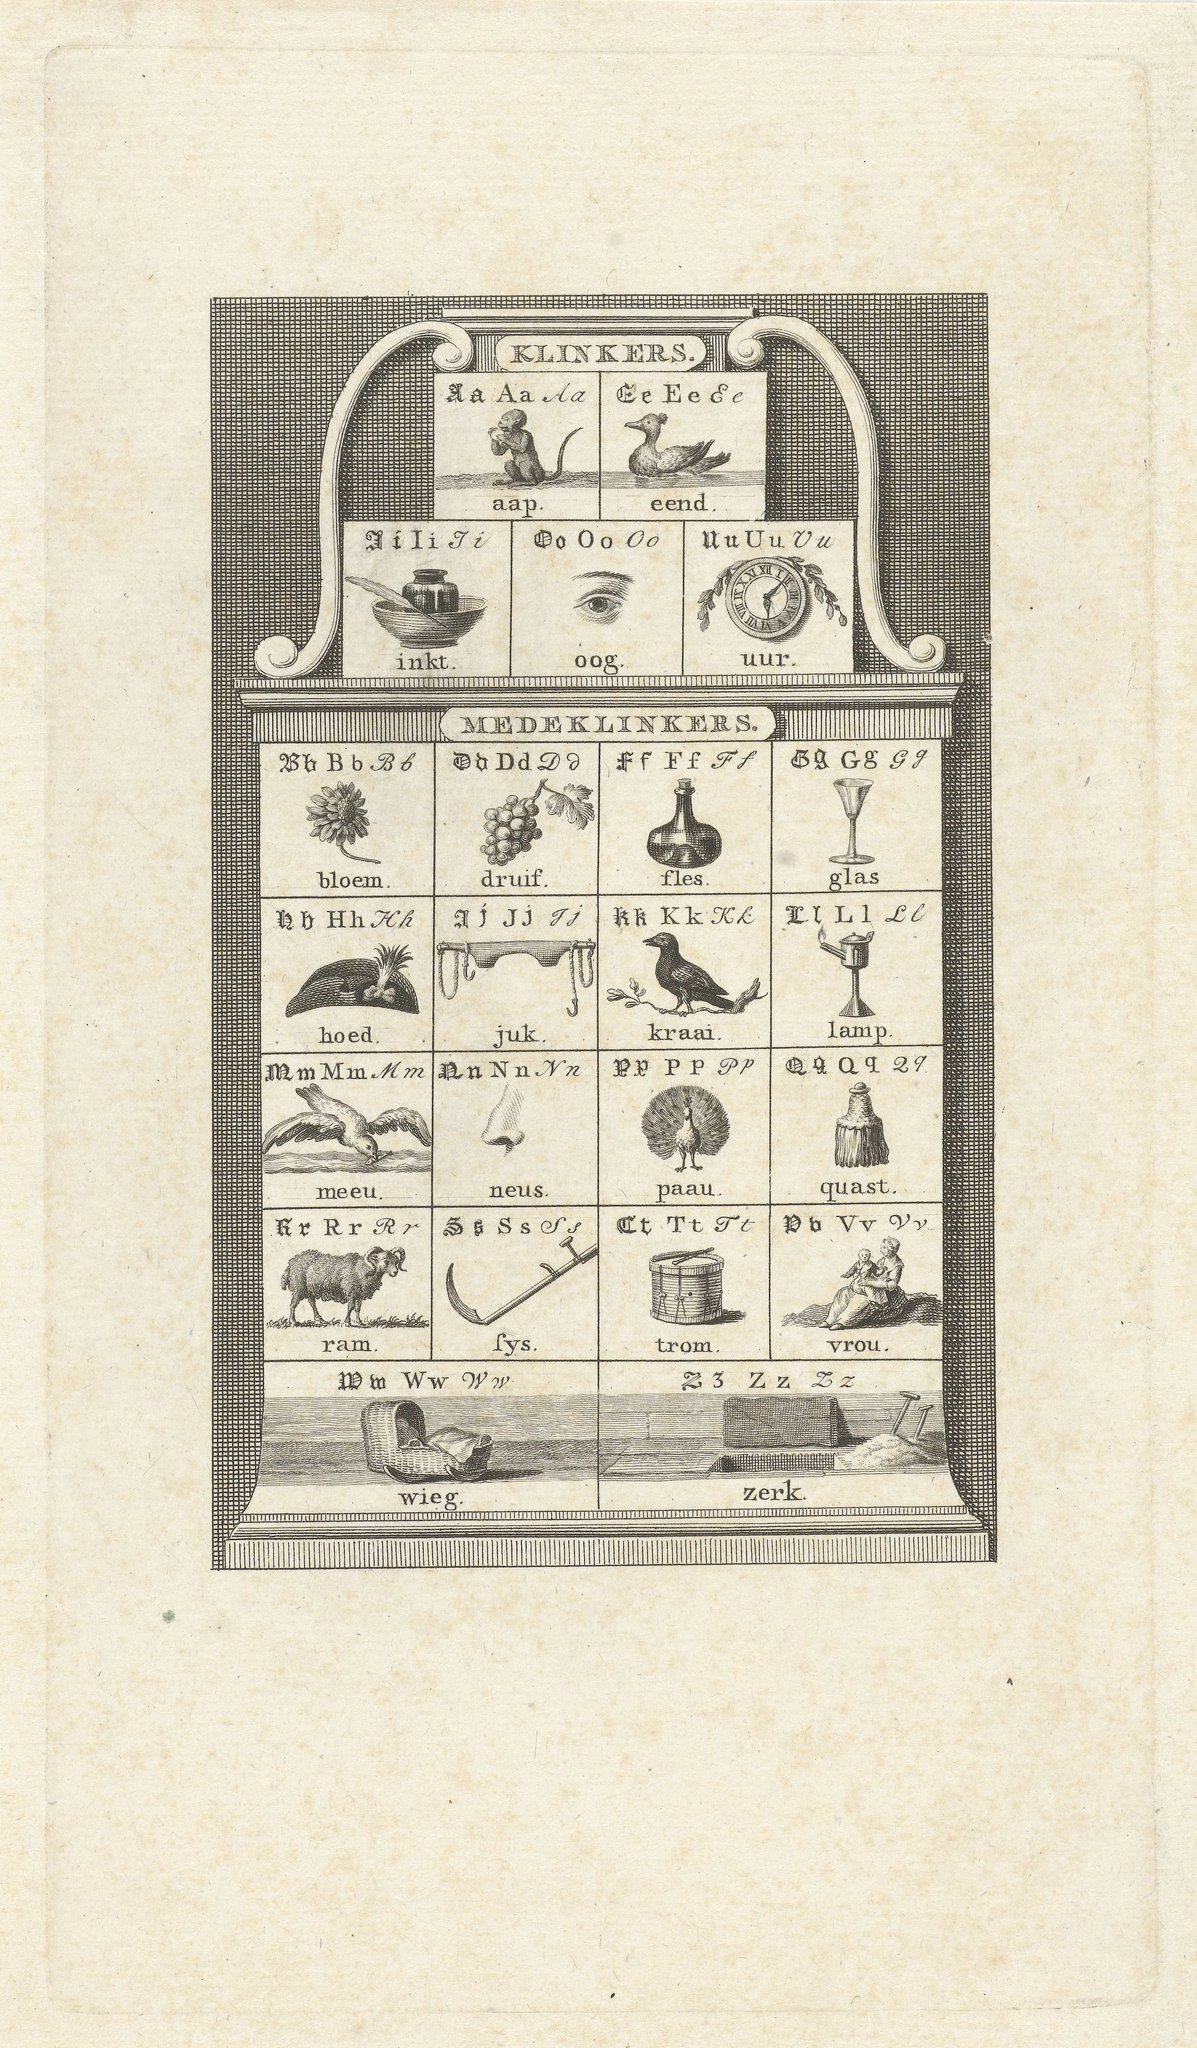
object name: print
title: Letters van het alfabet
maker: jacob folkema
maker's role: draughtsman, print maker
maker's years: 1692-1767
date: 1702-1767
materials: paper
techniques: etching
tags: letters, alphabet, script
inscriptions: collector's mark: Lugt 2228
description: De letters van het alfabet, gegroepeerd in klinkers en medeklinkers. Bij elke letter staat een afbeelding van een voorwerp dat begint met de betreffende letter.